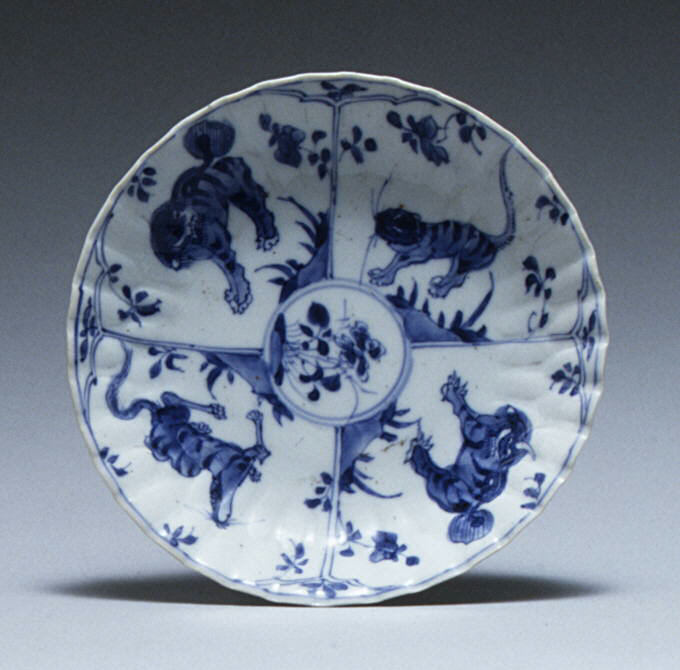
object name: saucer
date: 1701-1733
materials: hard paste porcelain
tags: animals